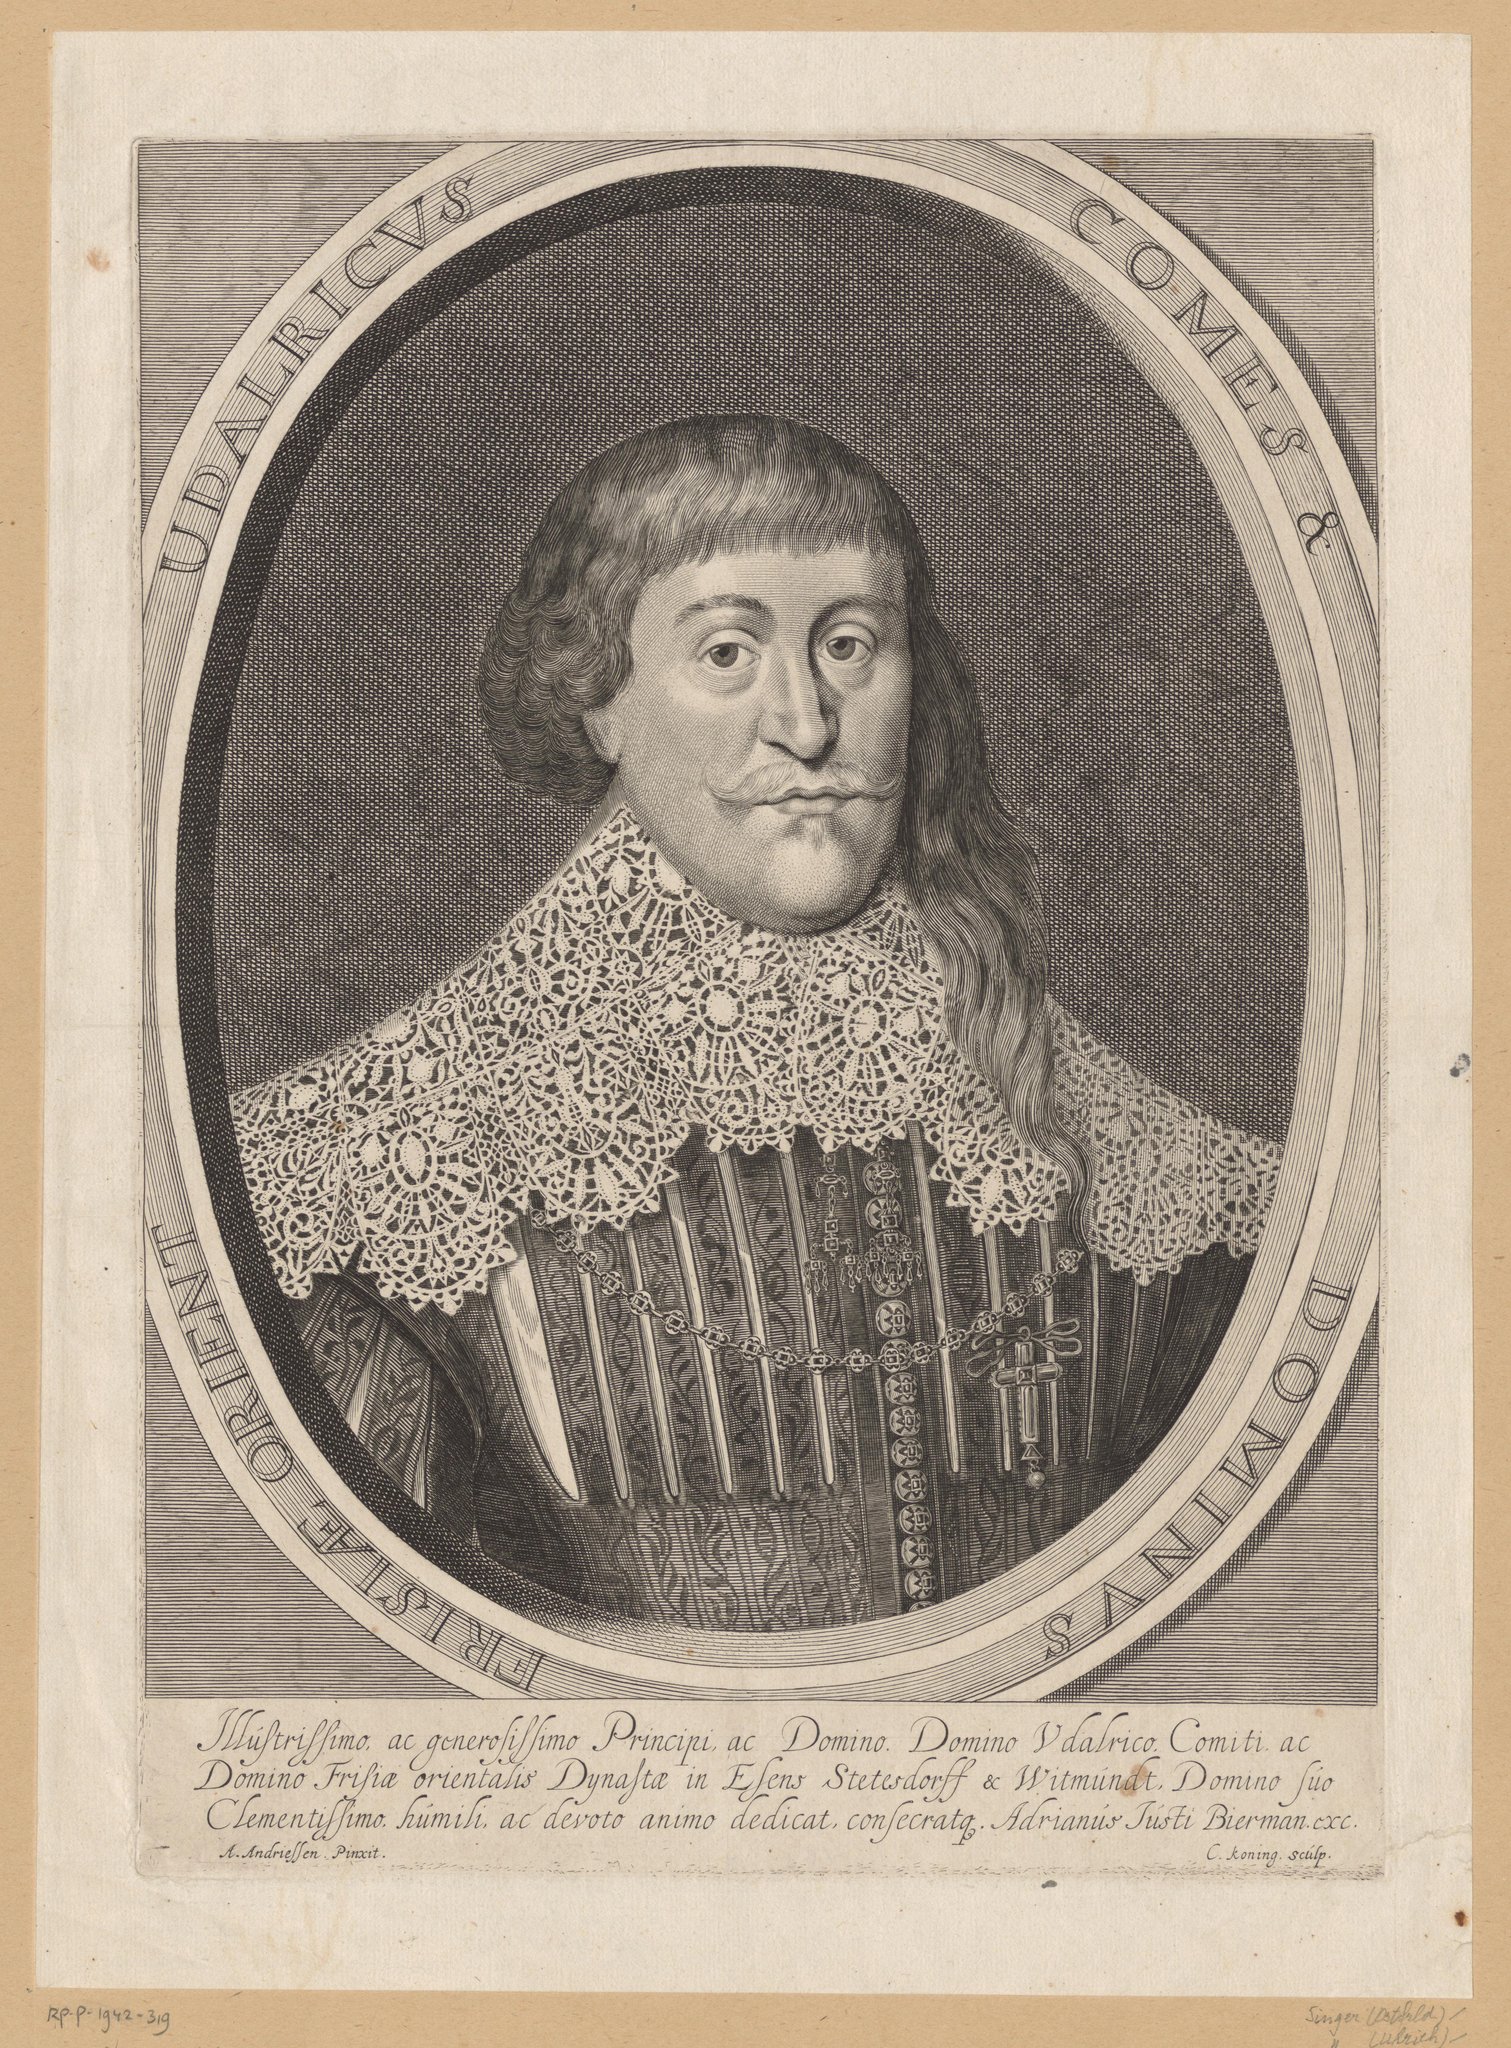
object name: print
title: Portret van Udalricus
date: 1608-1671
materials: paper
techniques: engraving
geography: haarlem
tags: styles of hairdress (lovelock), lace (+ men's clothes), historical persons, clothing for the upper part of the body (doublet) (+ men's clothes), neck-gear: collar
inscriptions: inscription: ‘Dit portret behoort tot een stel waarvan er/ 8 stuks bestaan, van de vorsten van Oost-Duitsland/ alle naar de schilderijen van A. Andriessen/ en gegraveerd door C. Koning’, collector's mark: Lugt 2228, watermark, collector's mark: Lugt 2760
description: Portret van Udalricus (Ulrich II), graaf van Oost-Friesland, in ovale omlijsting. Zijn kapsel is kort aan de ene kant en valt aan de andere kant in een lange 'liefdeslok' over de schouder. Hij draagt een platte brede kanten kraag. Onder het portret een opdracht door de uitgever.